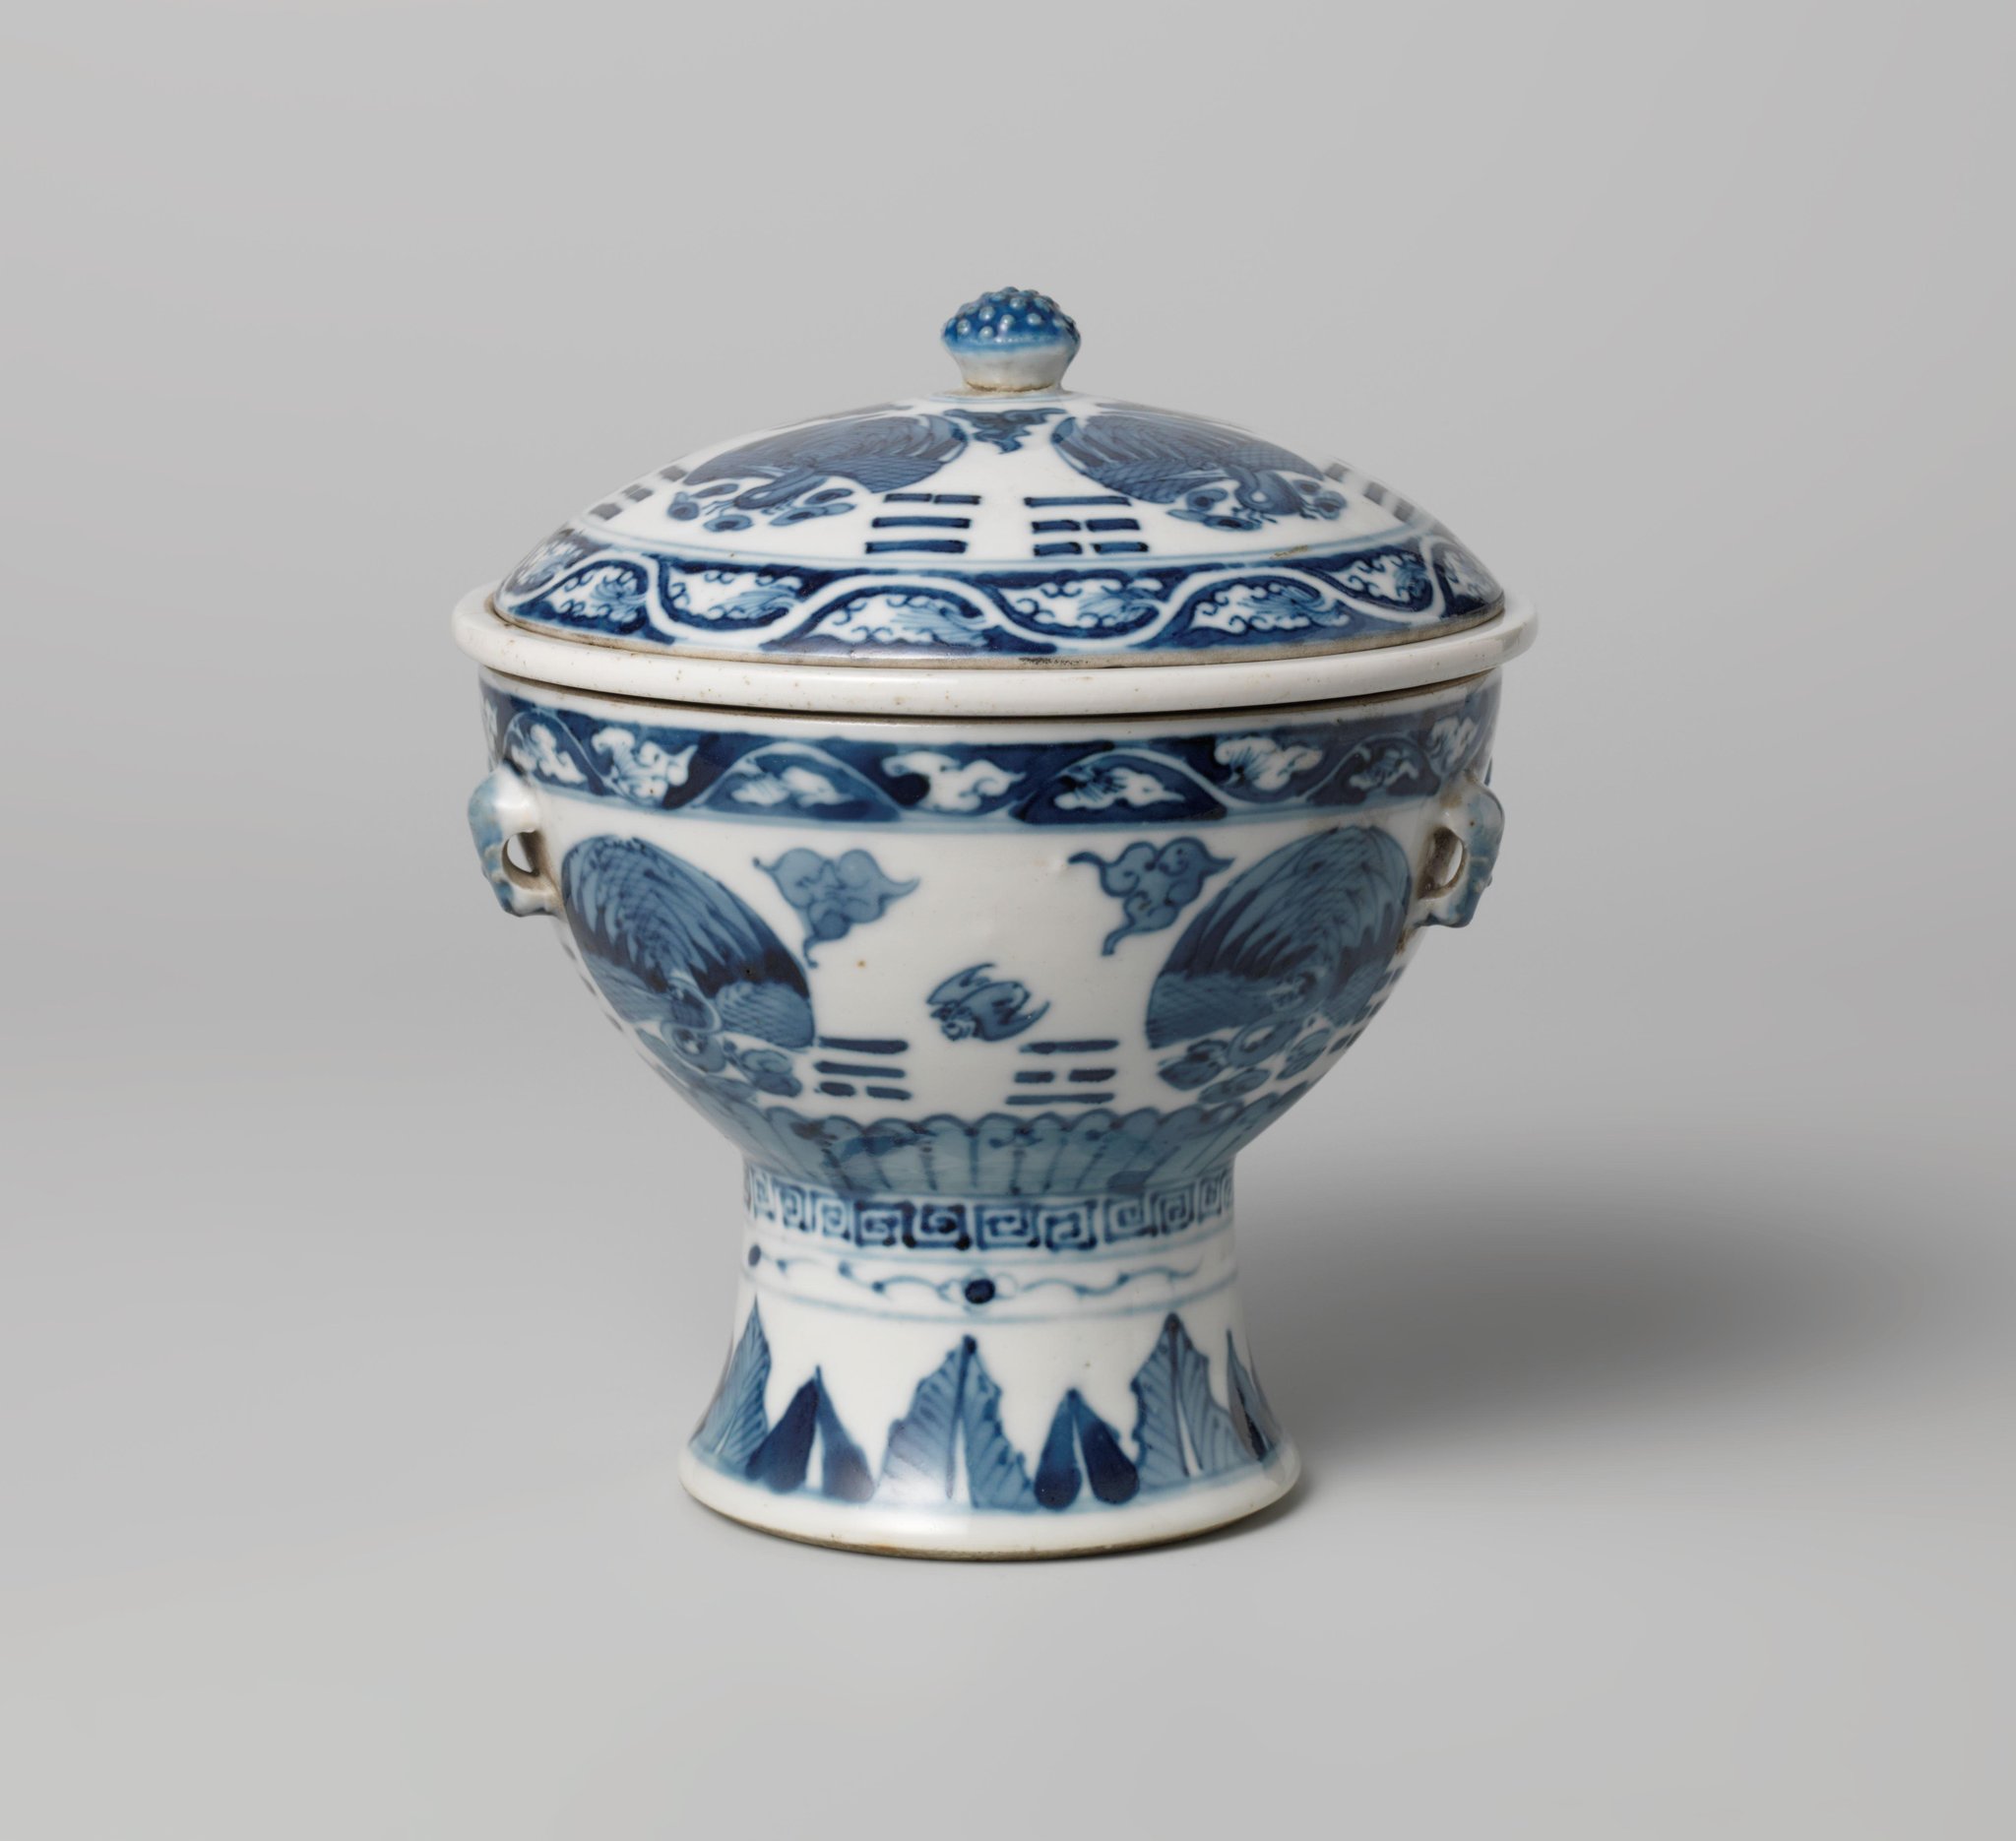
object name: komfoor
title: Brazier with crane-shaped medallions and ornamental borders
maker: Anonymous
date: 1675-1724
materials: cobalt, glaze, paint, porcelain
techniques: firing, turning, vitrification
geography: arita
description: Warmhouder, onderglazuur blauw met een feng huang in een cirkel op de wand van de kom, met deksel, op de buitenwand twee oortjes.